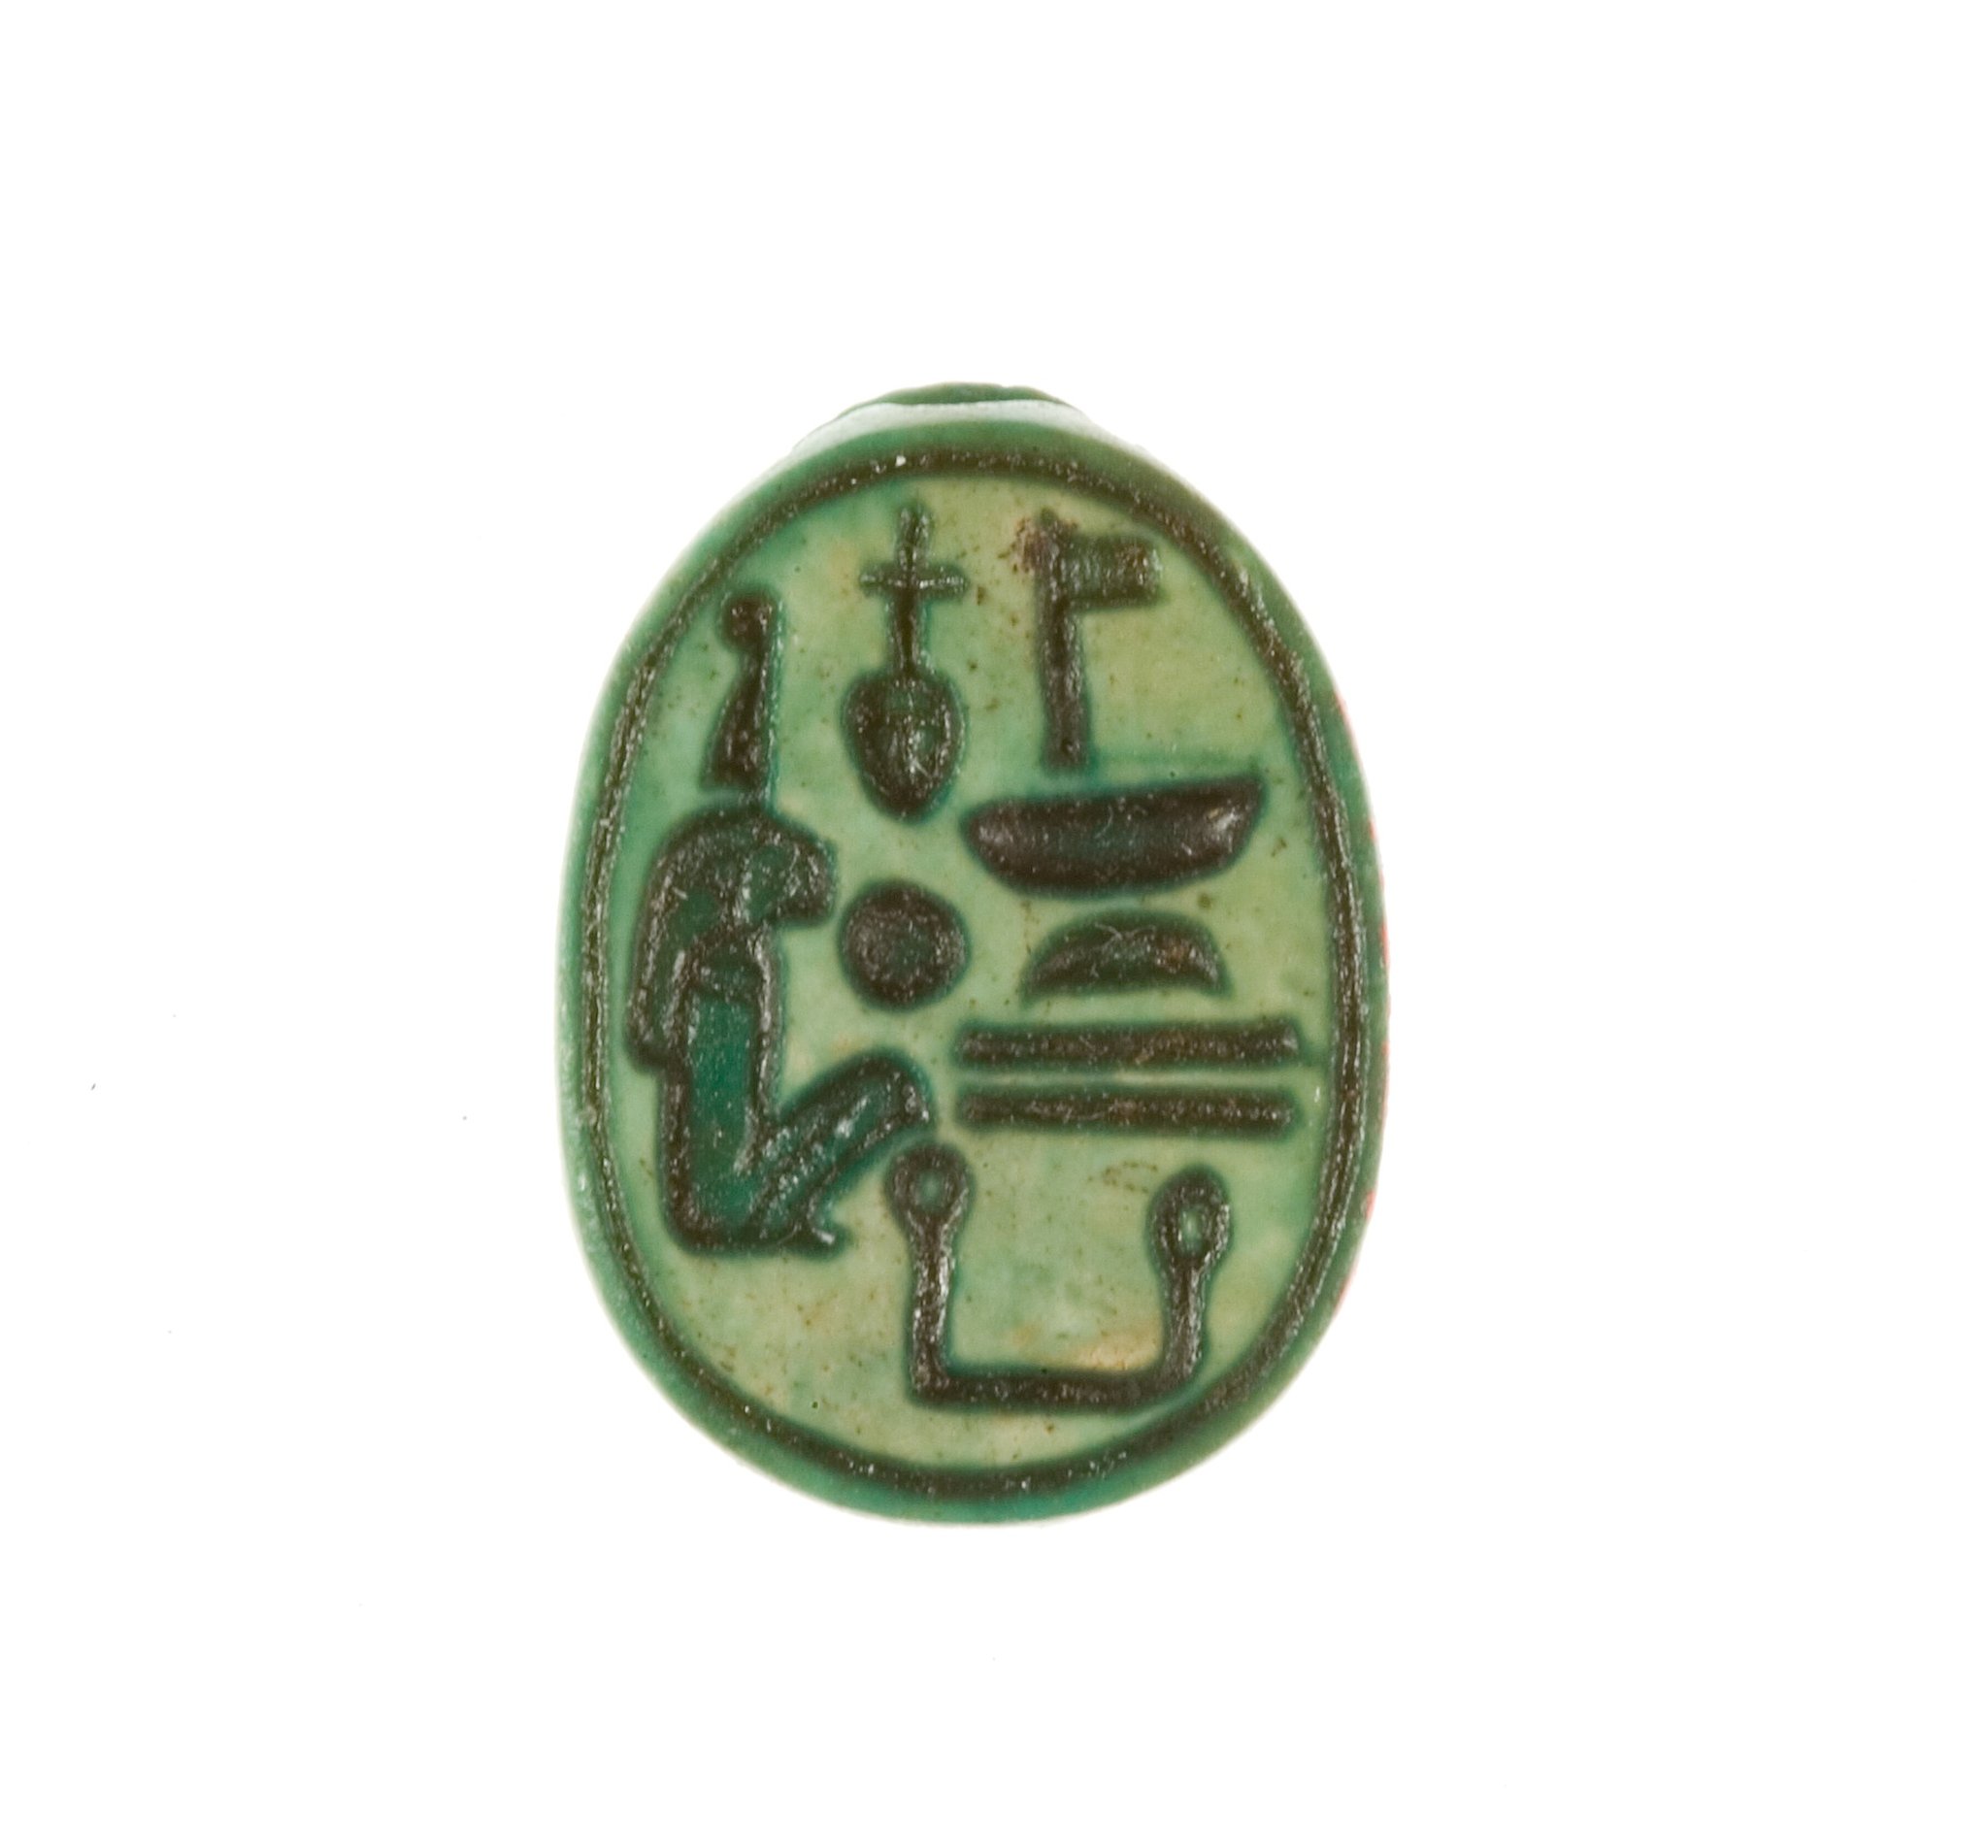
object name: scarab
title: Scarab Inscribed Perfect God, Lord of the Two Lands Maatkare (Hatshepsut)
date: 1479-1458 BCE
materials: stone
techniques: glazing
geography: egypt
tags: hieroglyphs,scarabs